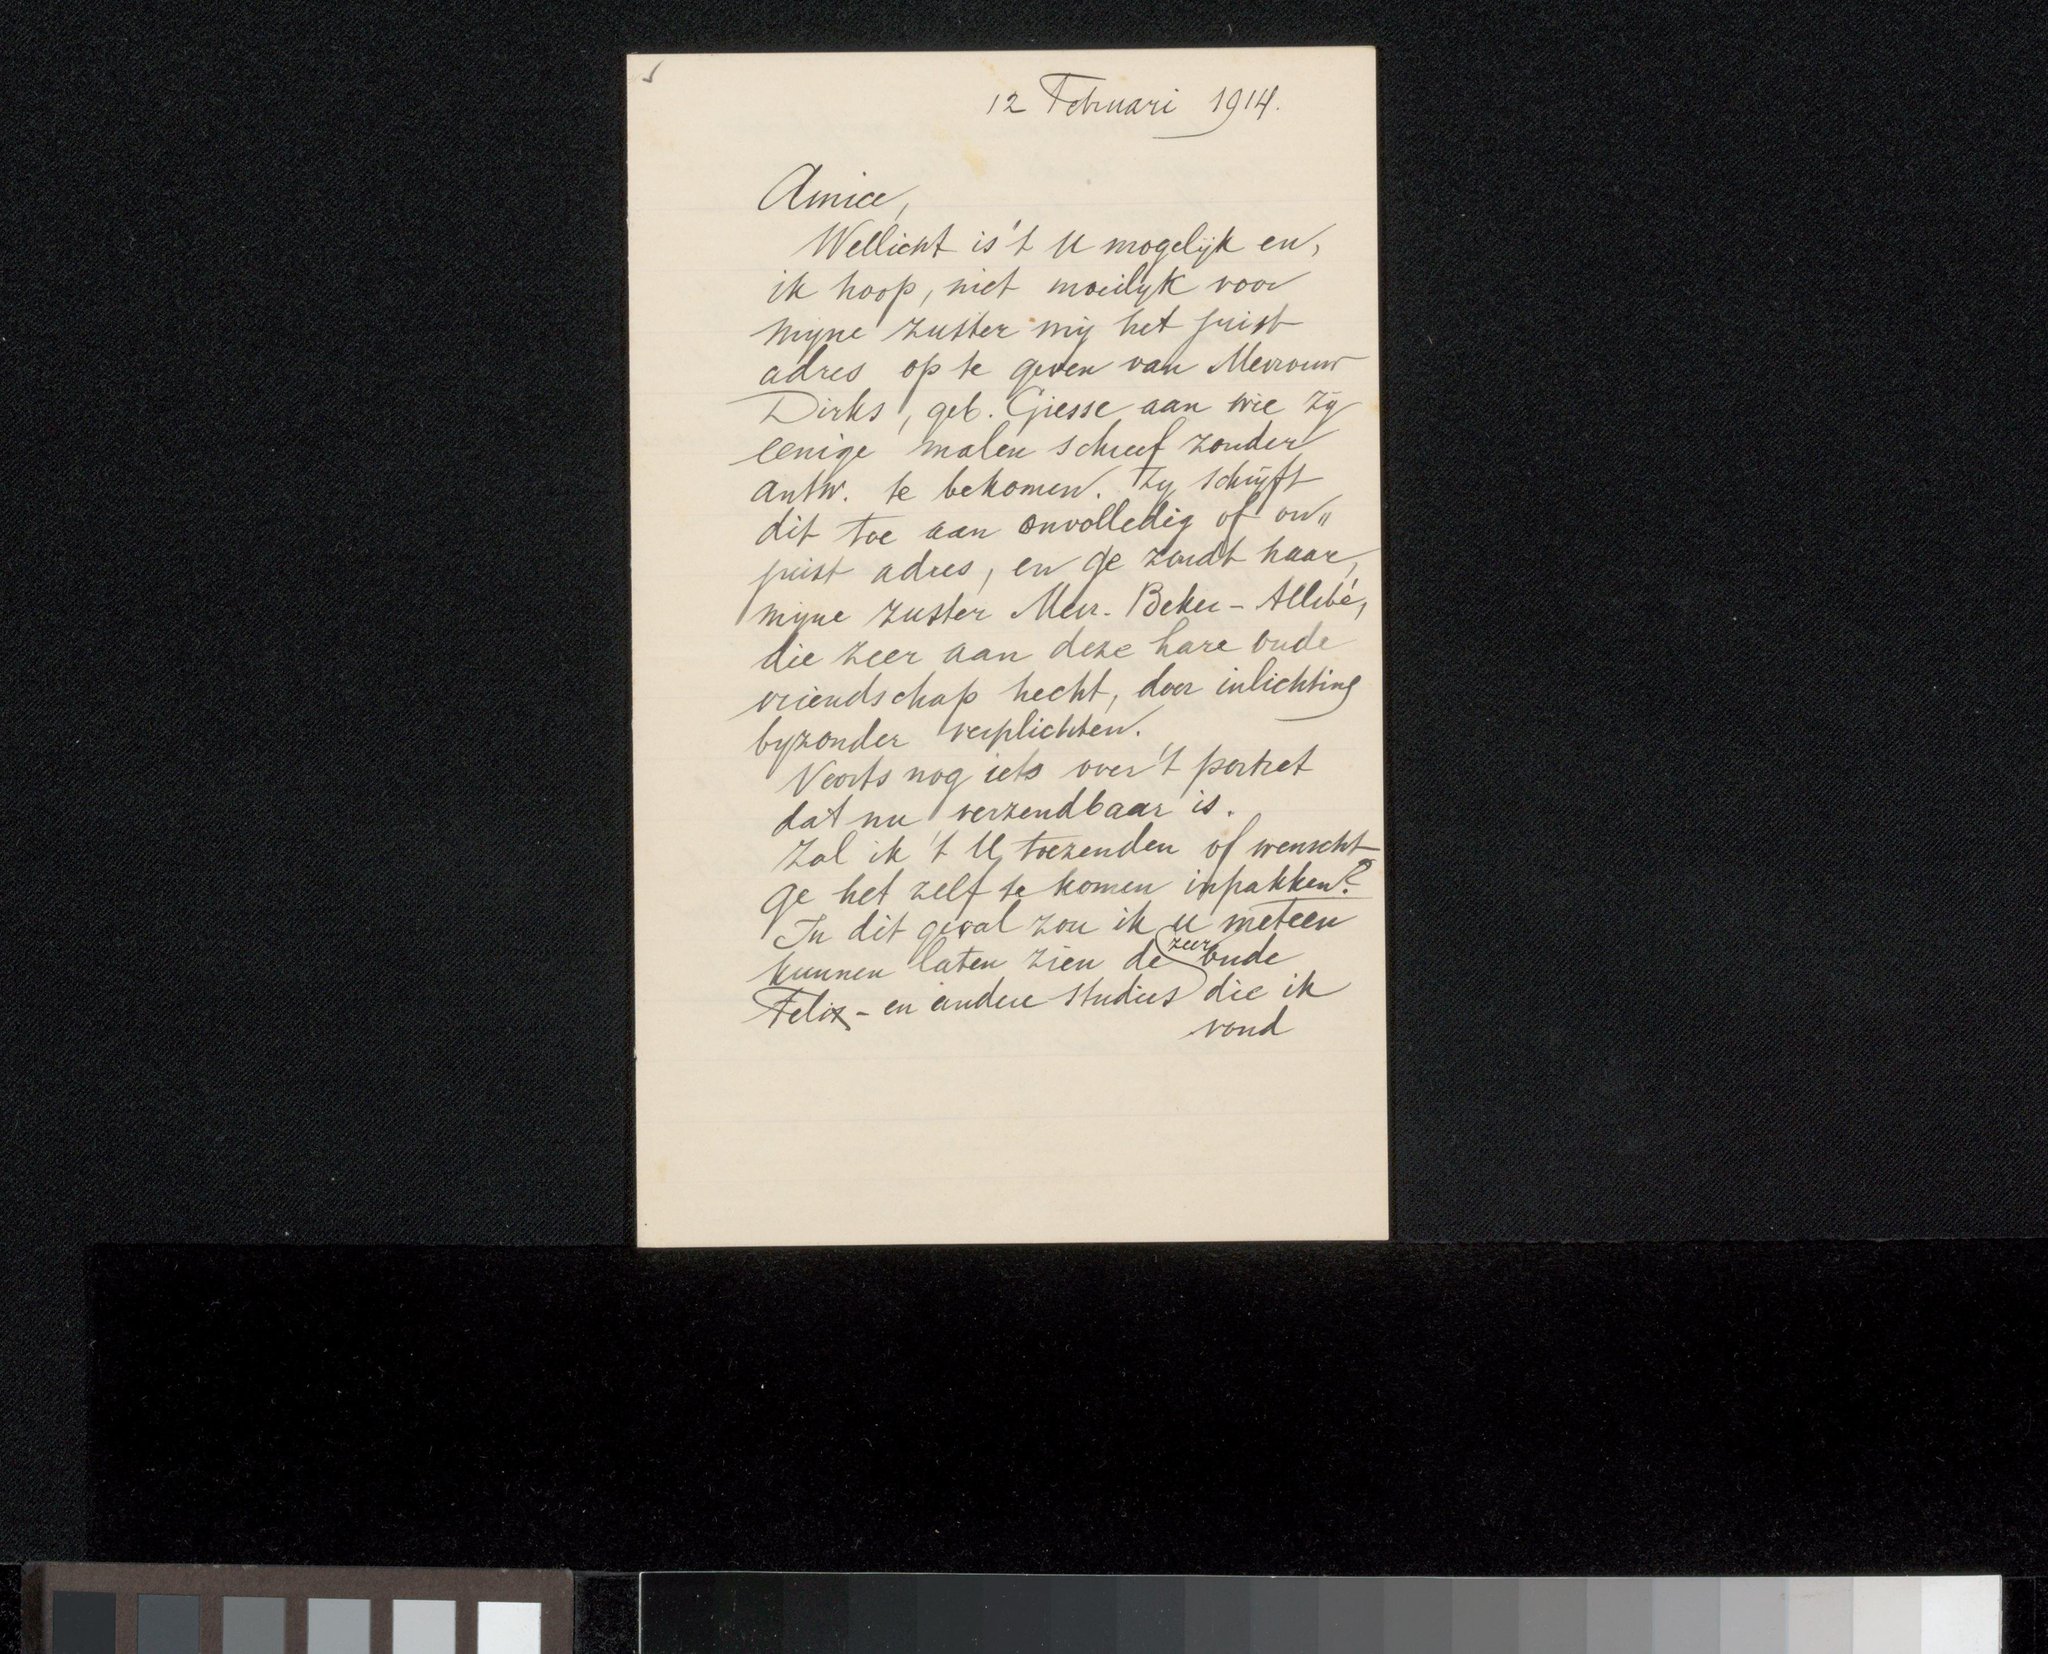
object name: letter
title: Brief aan Jan Veth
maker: august allebé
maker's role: draughtsman, print maker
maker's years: 1838-1927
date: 1914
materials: ink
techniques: pen, writing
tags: dordrecht, designer, jan veth, lyon, raymond de lafage, haarlem, painter, print maker, draughtsman, jac van looij, leiden, rembrandt van rijn, art trade, art shop, drawing, the graphic arts, anonymous historical person portrayed, money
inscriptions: collector's mark: ‘RPK’